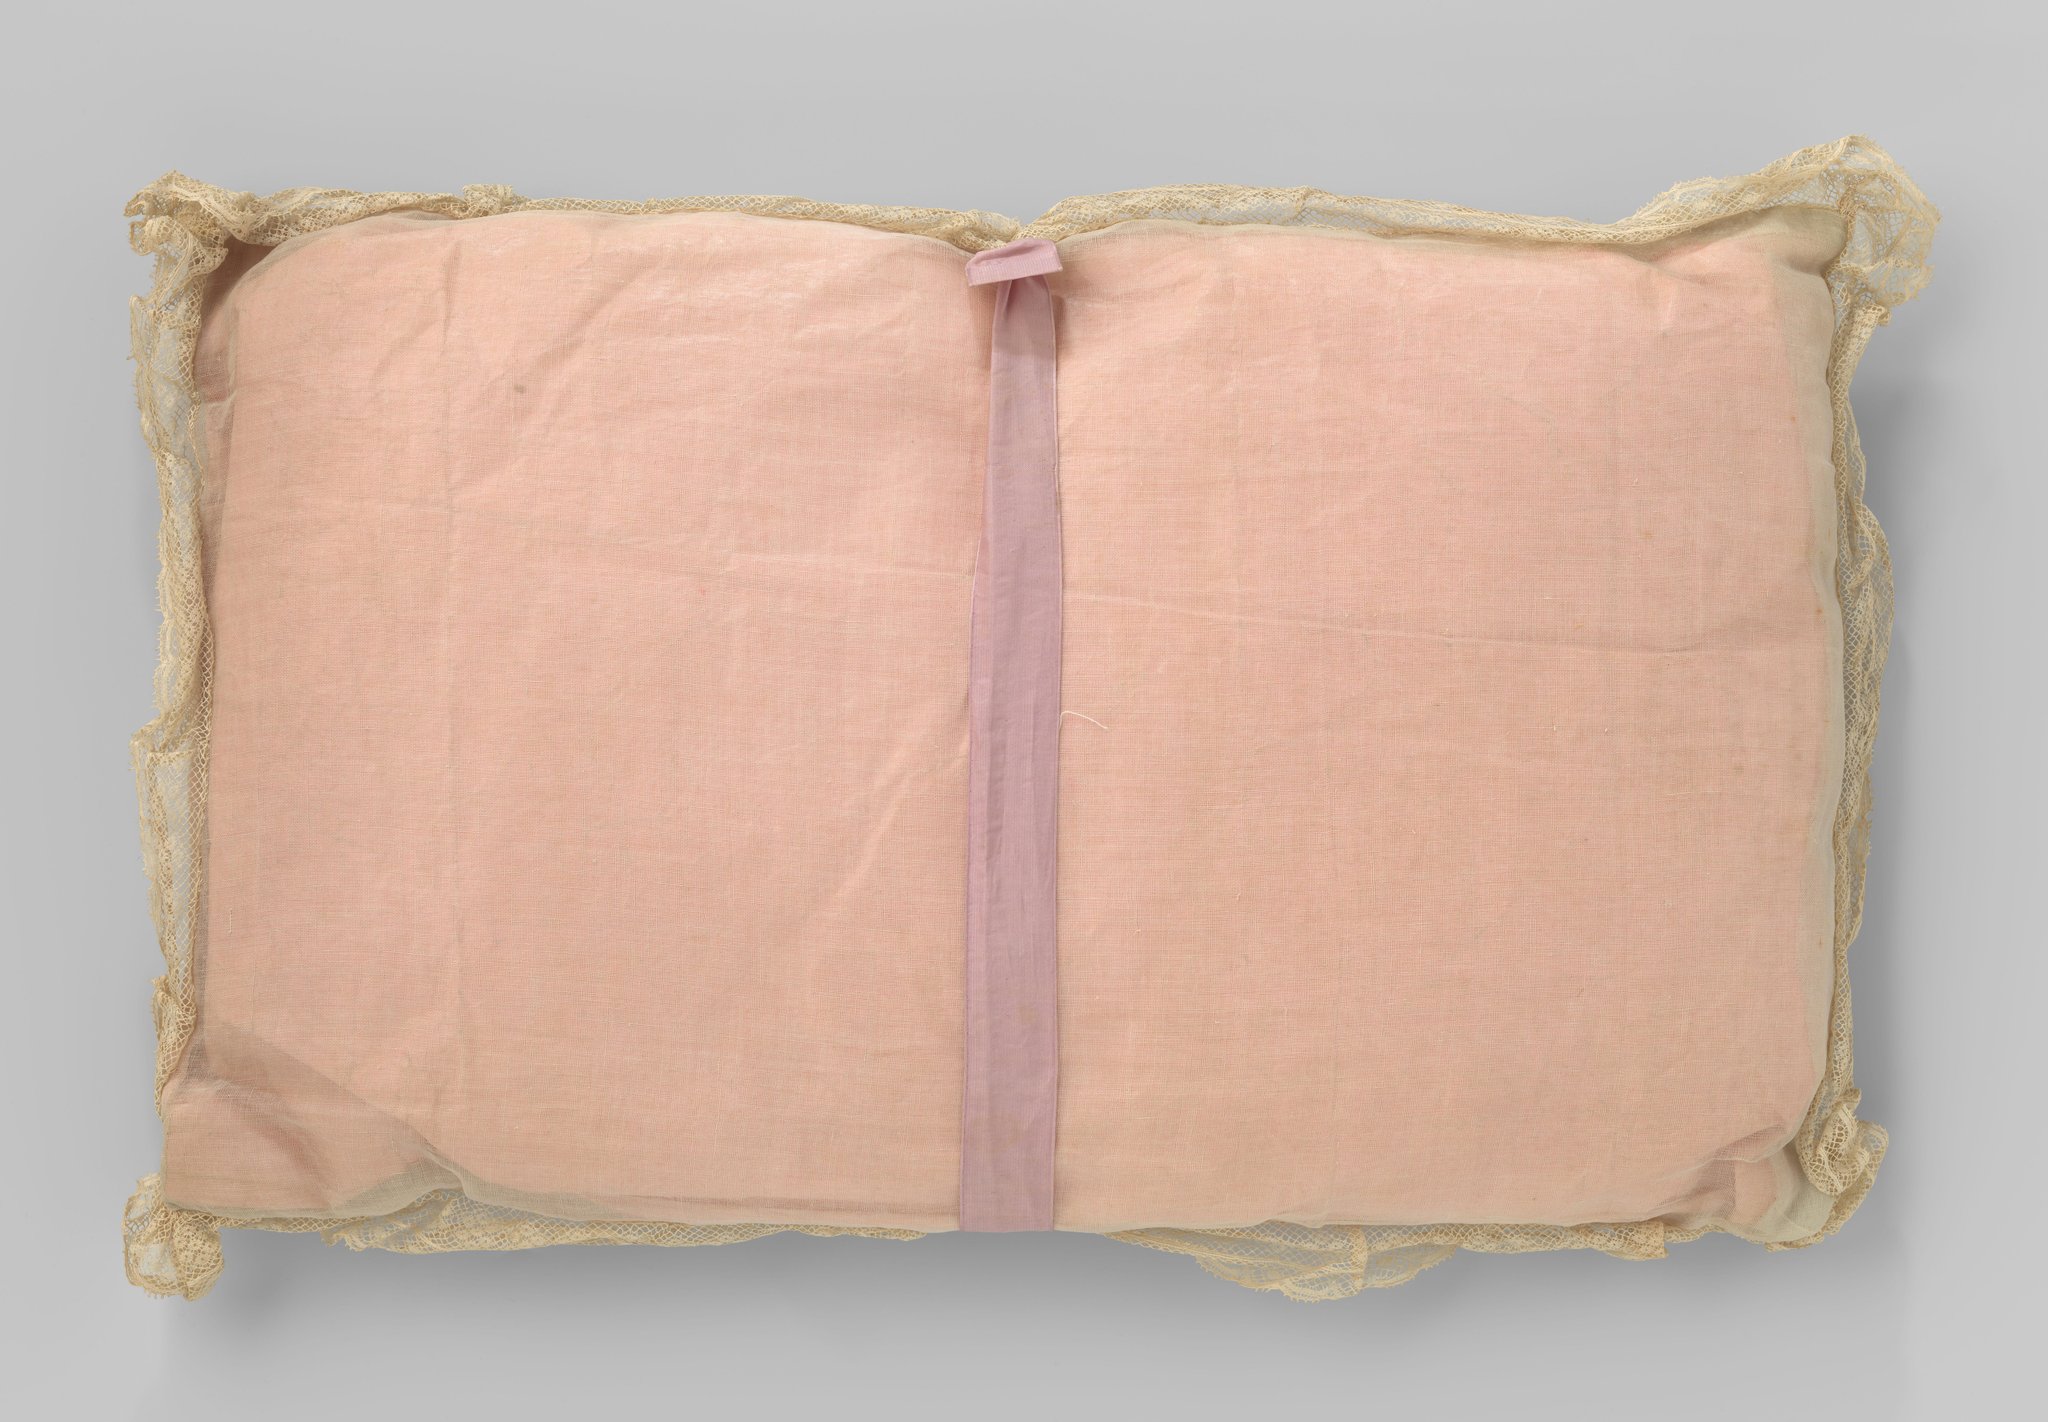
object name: cushion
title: Rechthoekig kussen, van roze textiel, met overtrek van kant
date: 1836-1898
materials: textile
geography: netherlands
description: Rechthoekig kussen, van roze textiel, met overtrek van kant. Over de korte kant van het kussen is een lint gestrikt.